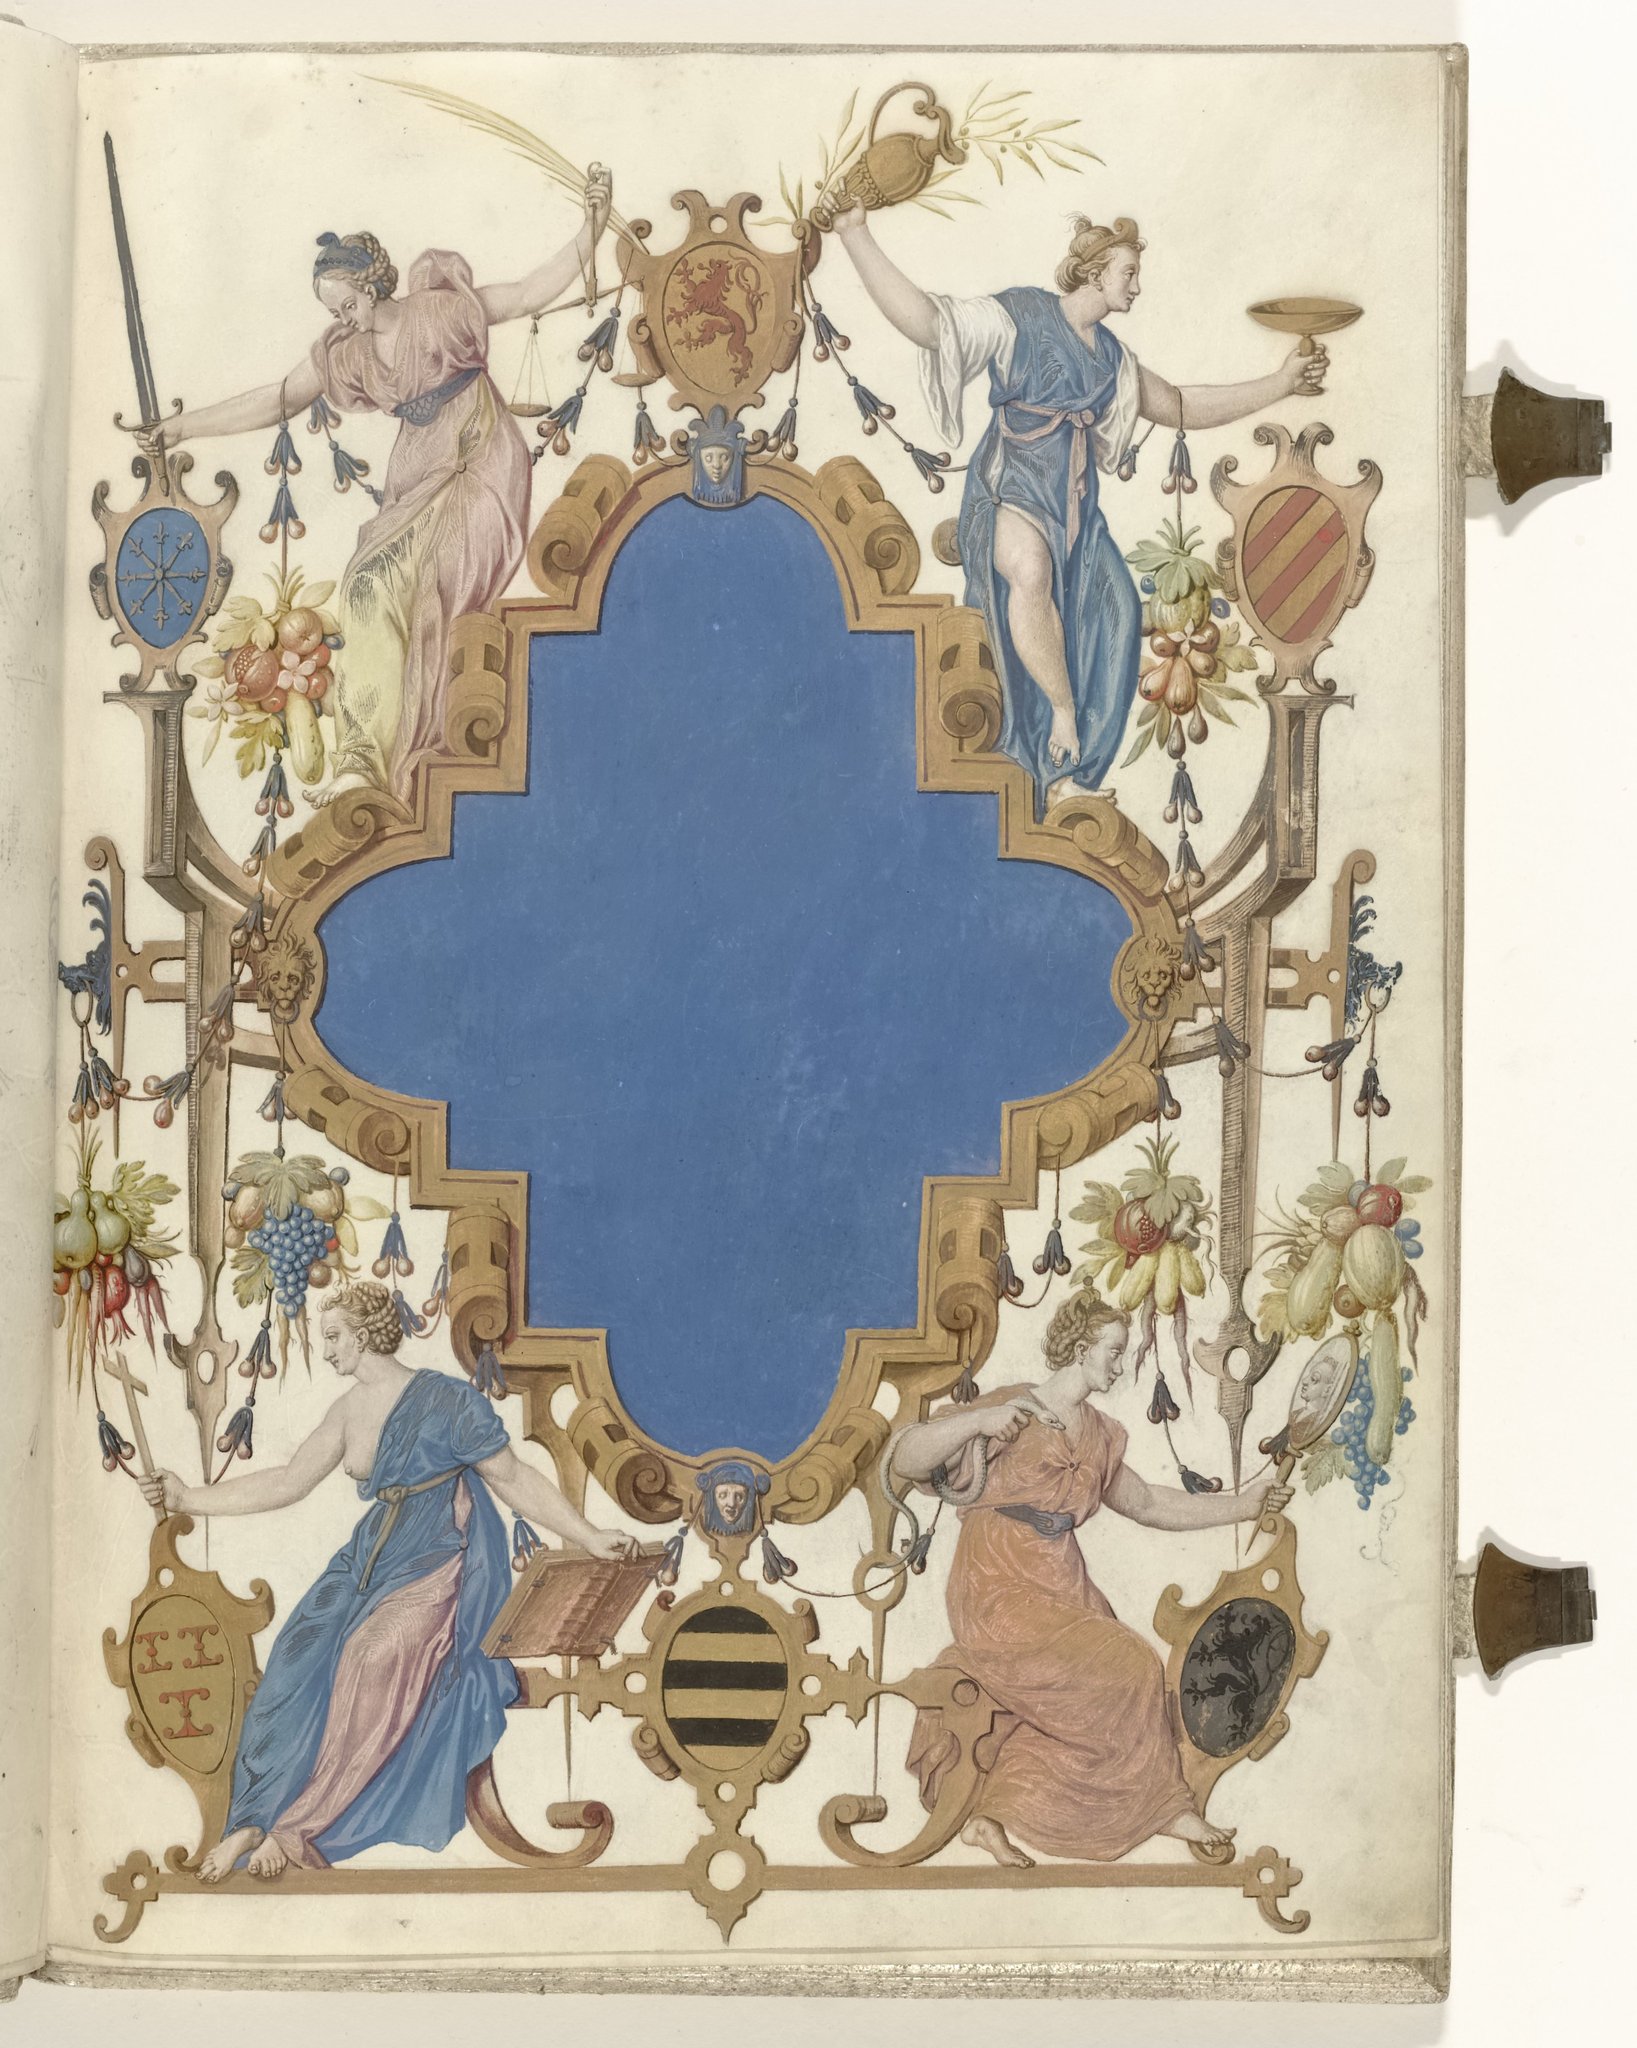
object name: drawing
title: Title page with cartouche surrounded by four allegorical figures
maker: nicolaes de kemp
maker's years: 1550-1633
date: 1590-1593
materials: paint, gouache, ink, parchment, watercolor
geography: northern netherlands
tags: temperance, 'temperantia'; 'temperanza' (ripa) ~ one of the four cardinal virtues, justice, 'justitia'; 'giustitia divina' (ripa) ~ one of the four cardinal virtues, prudence, 'prudentia'; 'prudenza' (ripa) ~ one of the four cardinal virtues, faith, 'fides'; 'fede', 'fede catholica', 'fede christiana', 'fede christiana catholica' (ripa) ~ one of the three theological virtues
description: Titelblad met een ornamentale cartouche zonder tekst. Met vier vrouwelijke personificaties van de deugden: Matigheid, Voorzichtigheid, Geloof en Rechtvaardigheid en de wapens van o.a. Van Beusichem, Teisterbant, Culemborg en Van Pallandt. Onderdeel van geïllustreerd handschrift met de genealogie van de heren en graven van Culemborg.